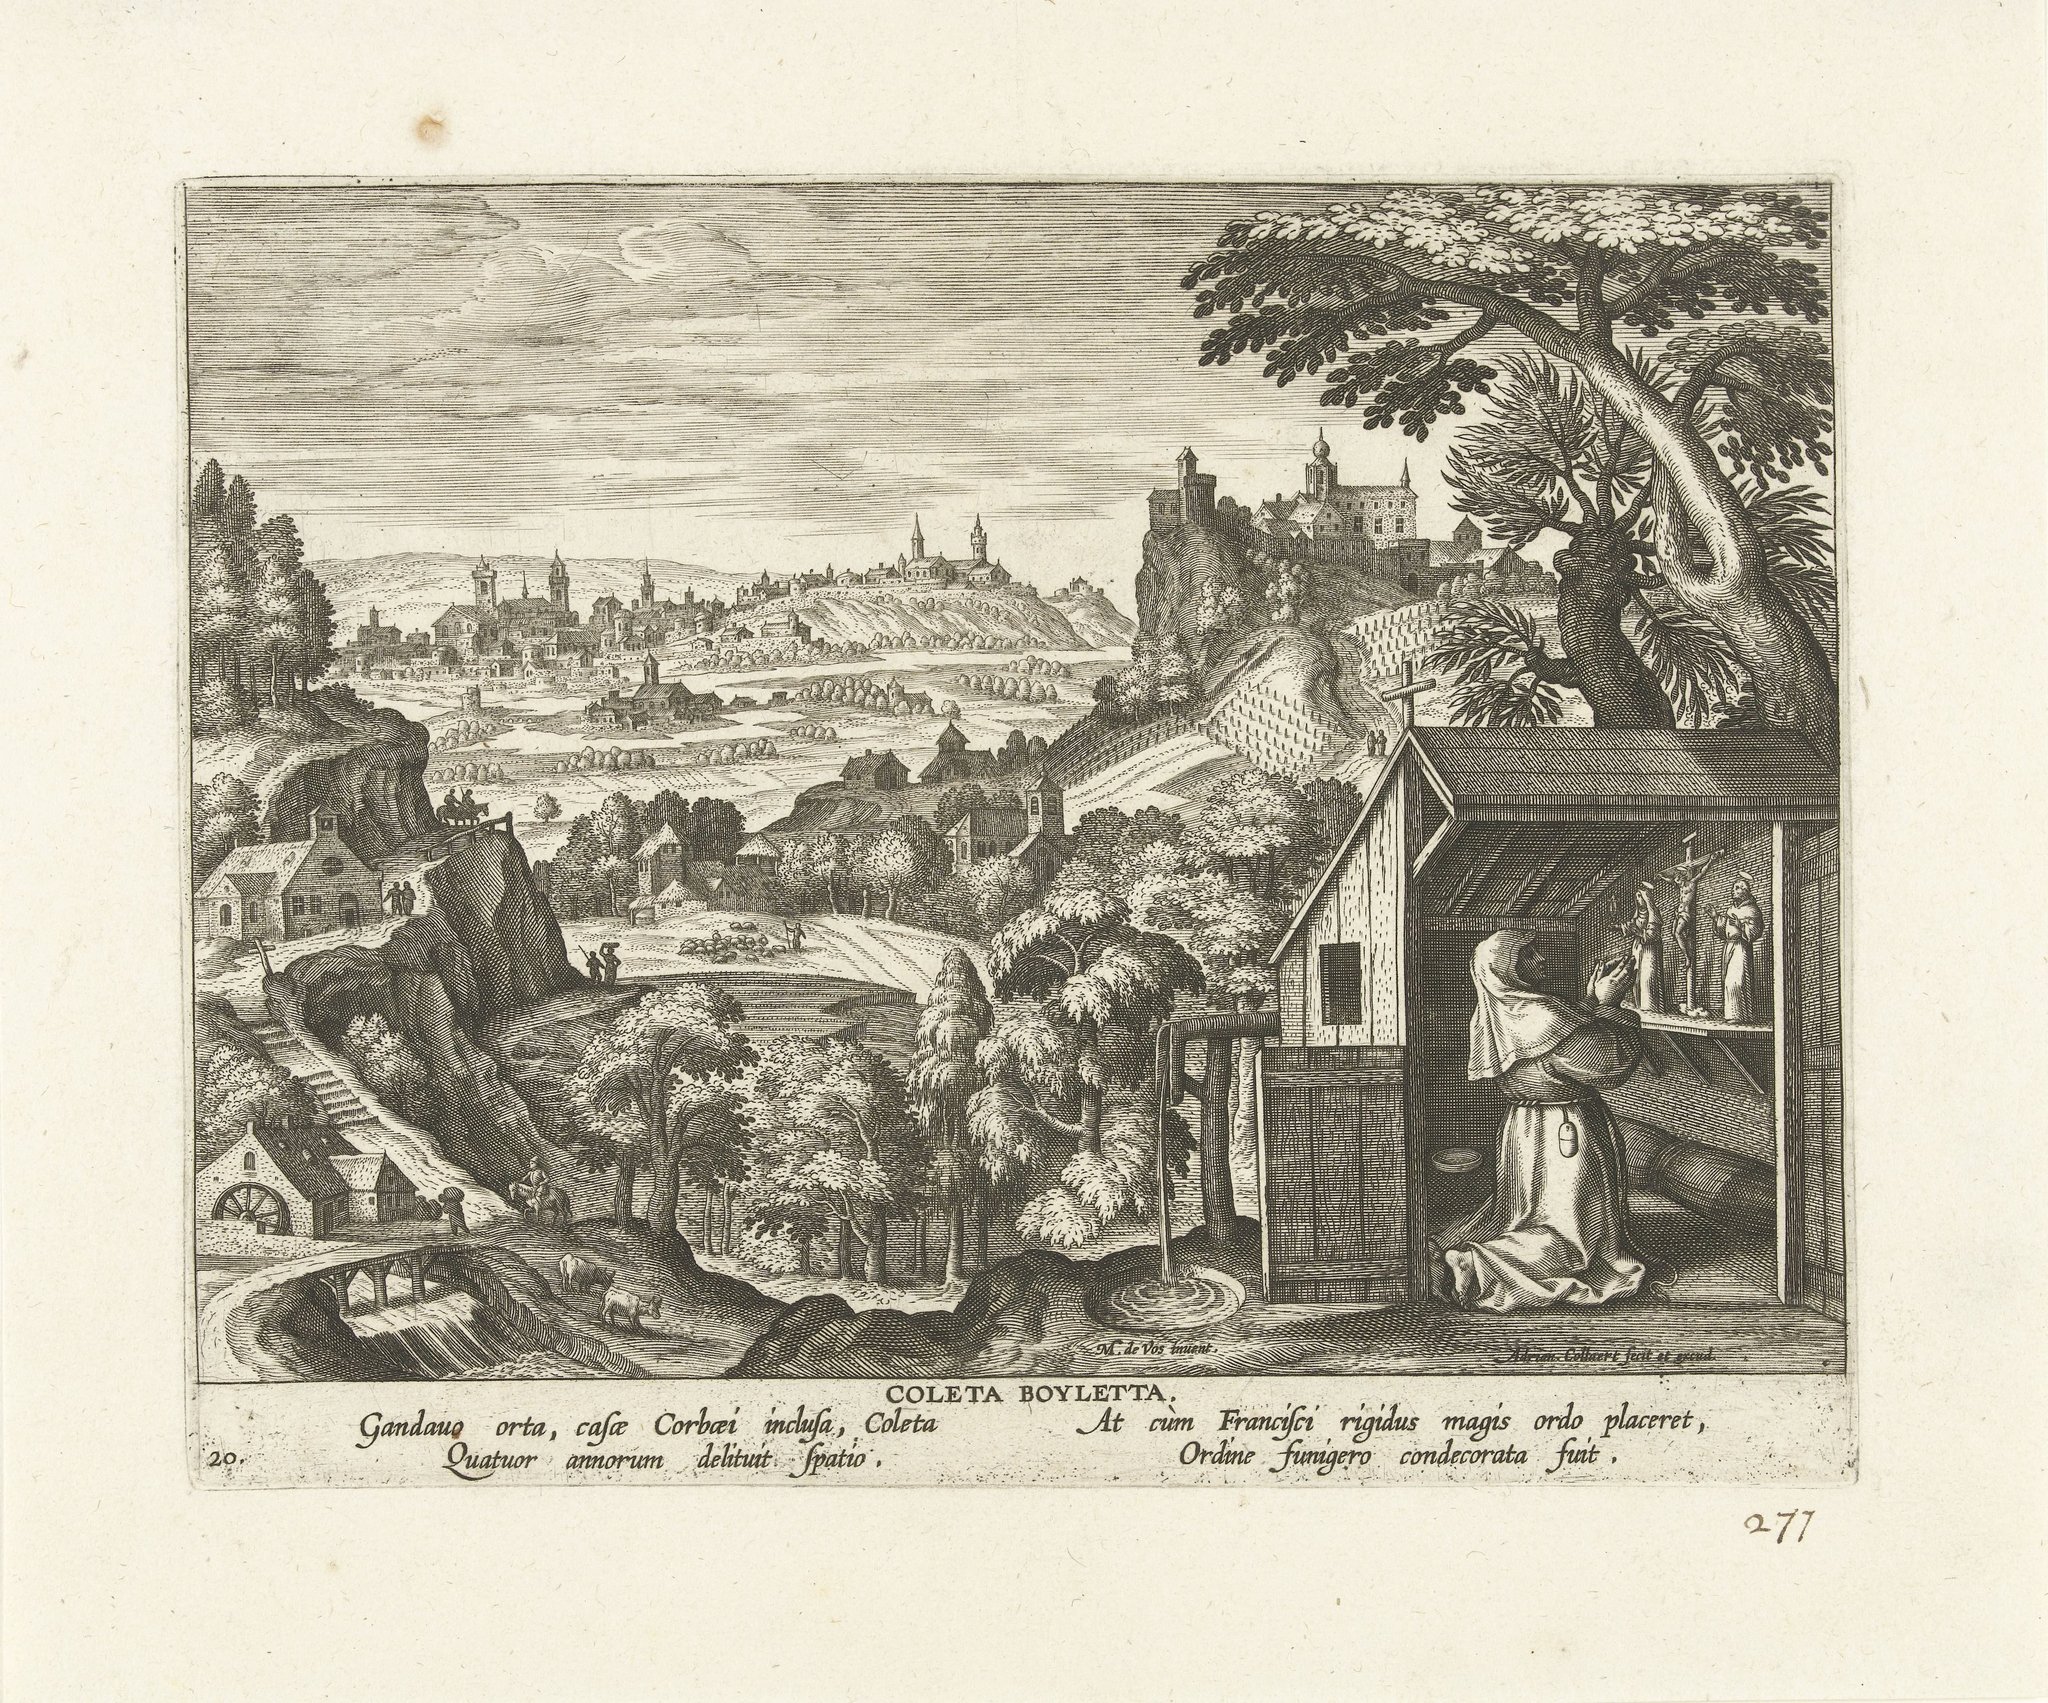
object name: print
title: Coleta Boyletta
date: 1570-1618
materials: paper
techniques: engraving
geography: antwerp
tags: anchorite, hermit, female saints (with name)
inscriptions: number: ‘272’, collector's mark: Lugt 2228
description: De heilige Coleta van Corbie bidt op haar knieën voor een kruisbeeld in een klein kapelletje. Op de achtergrond een landschap. De prent heeft een Latijns onderschrift en maakt deel uit van een serie met als onderwerp vrouwelijke kluizenaars.